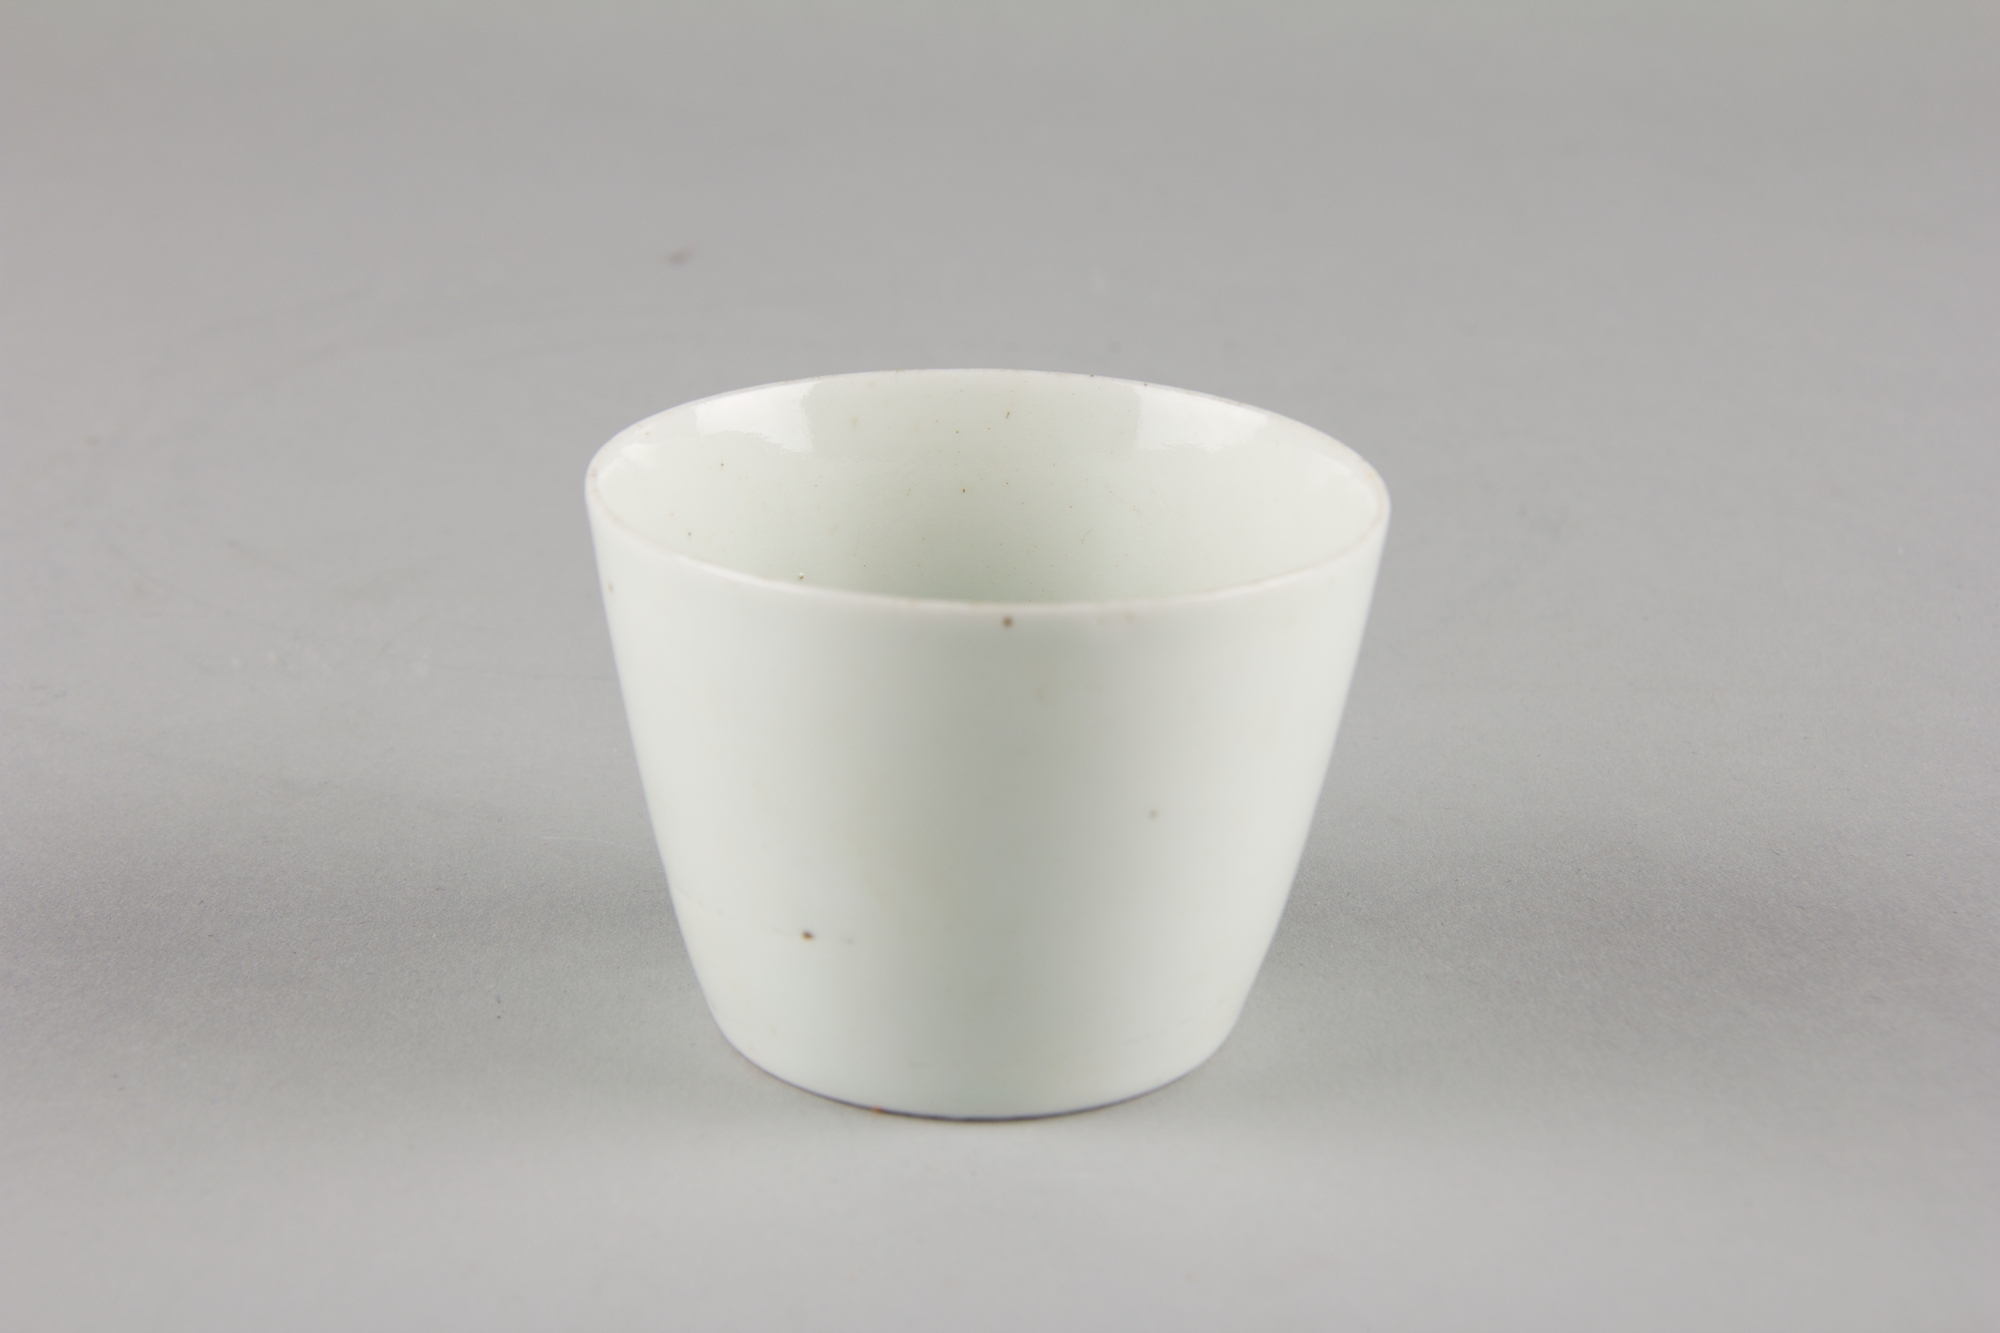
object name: soba cup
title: One from a Set of Five Soba Cups with Chrysanthemum Design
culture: japanese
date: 1615-1868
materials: porcelain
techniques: underglaze